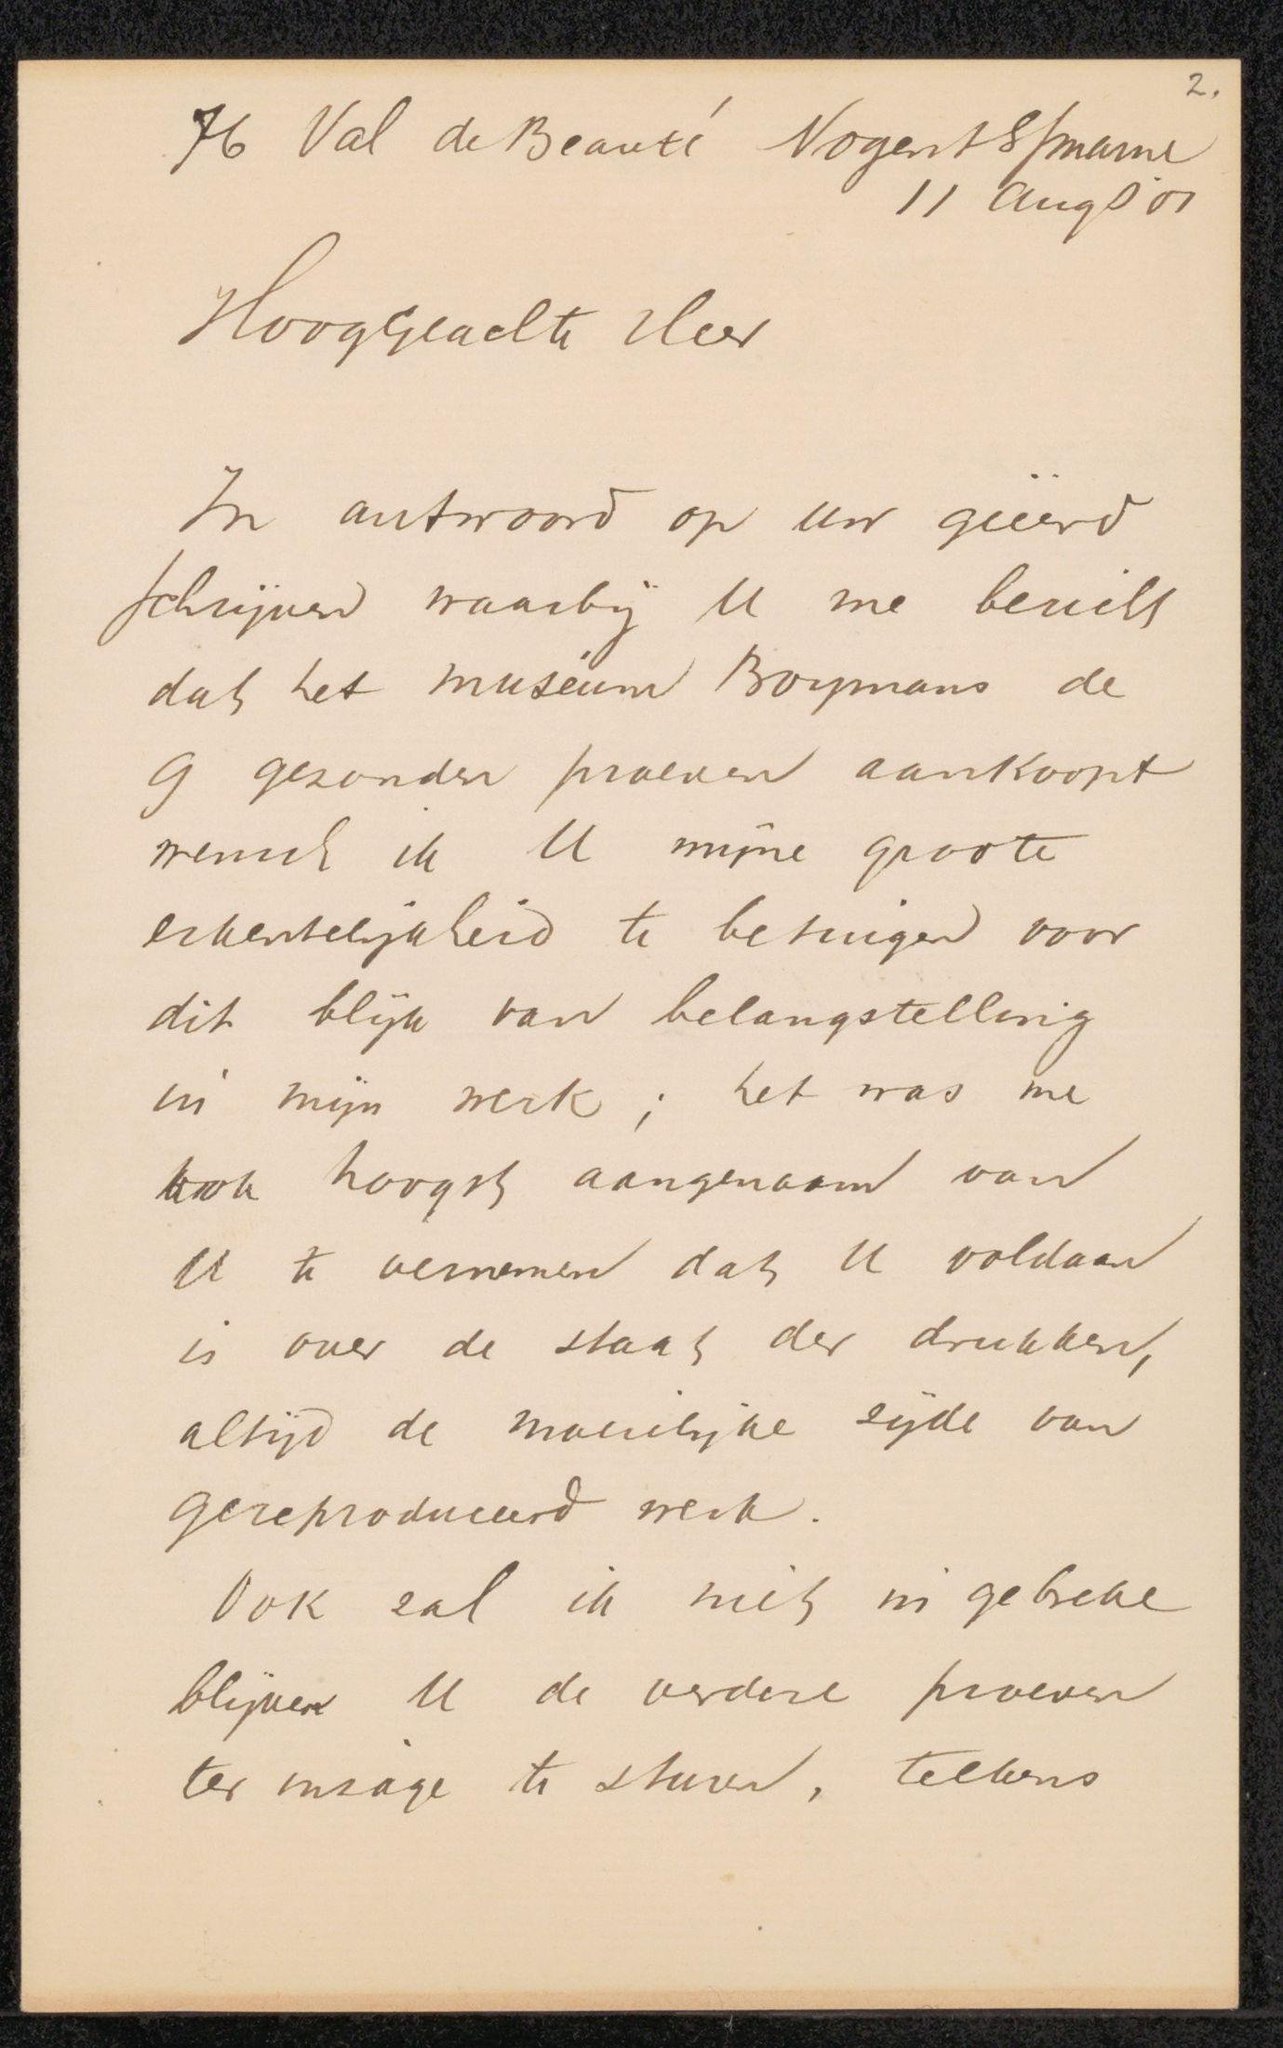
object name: letter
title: Brief aan Pieter Haverkorn van Rijsewijk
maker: pieter dupont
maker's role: draughtsman, print maker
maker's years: 1870-1911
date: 1901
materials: ink, paper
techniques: pen, writing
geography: nogent-sur-marne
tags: pieter haverkorn van rijsewijk, the graphic arts, art collecting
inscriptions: collector's mark: ‘RPK’, watermark